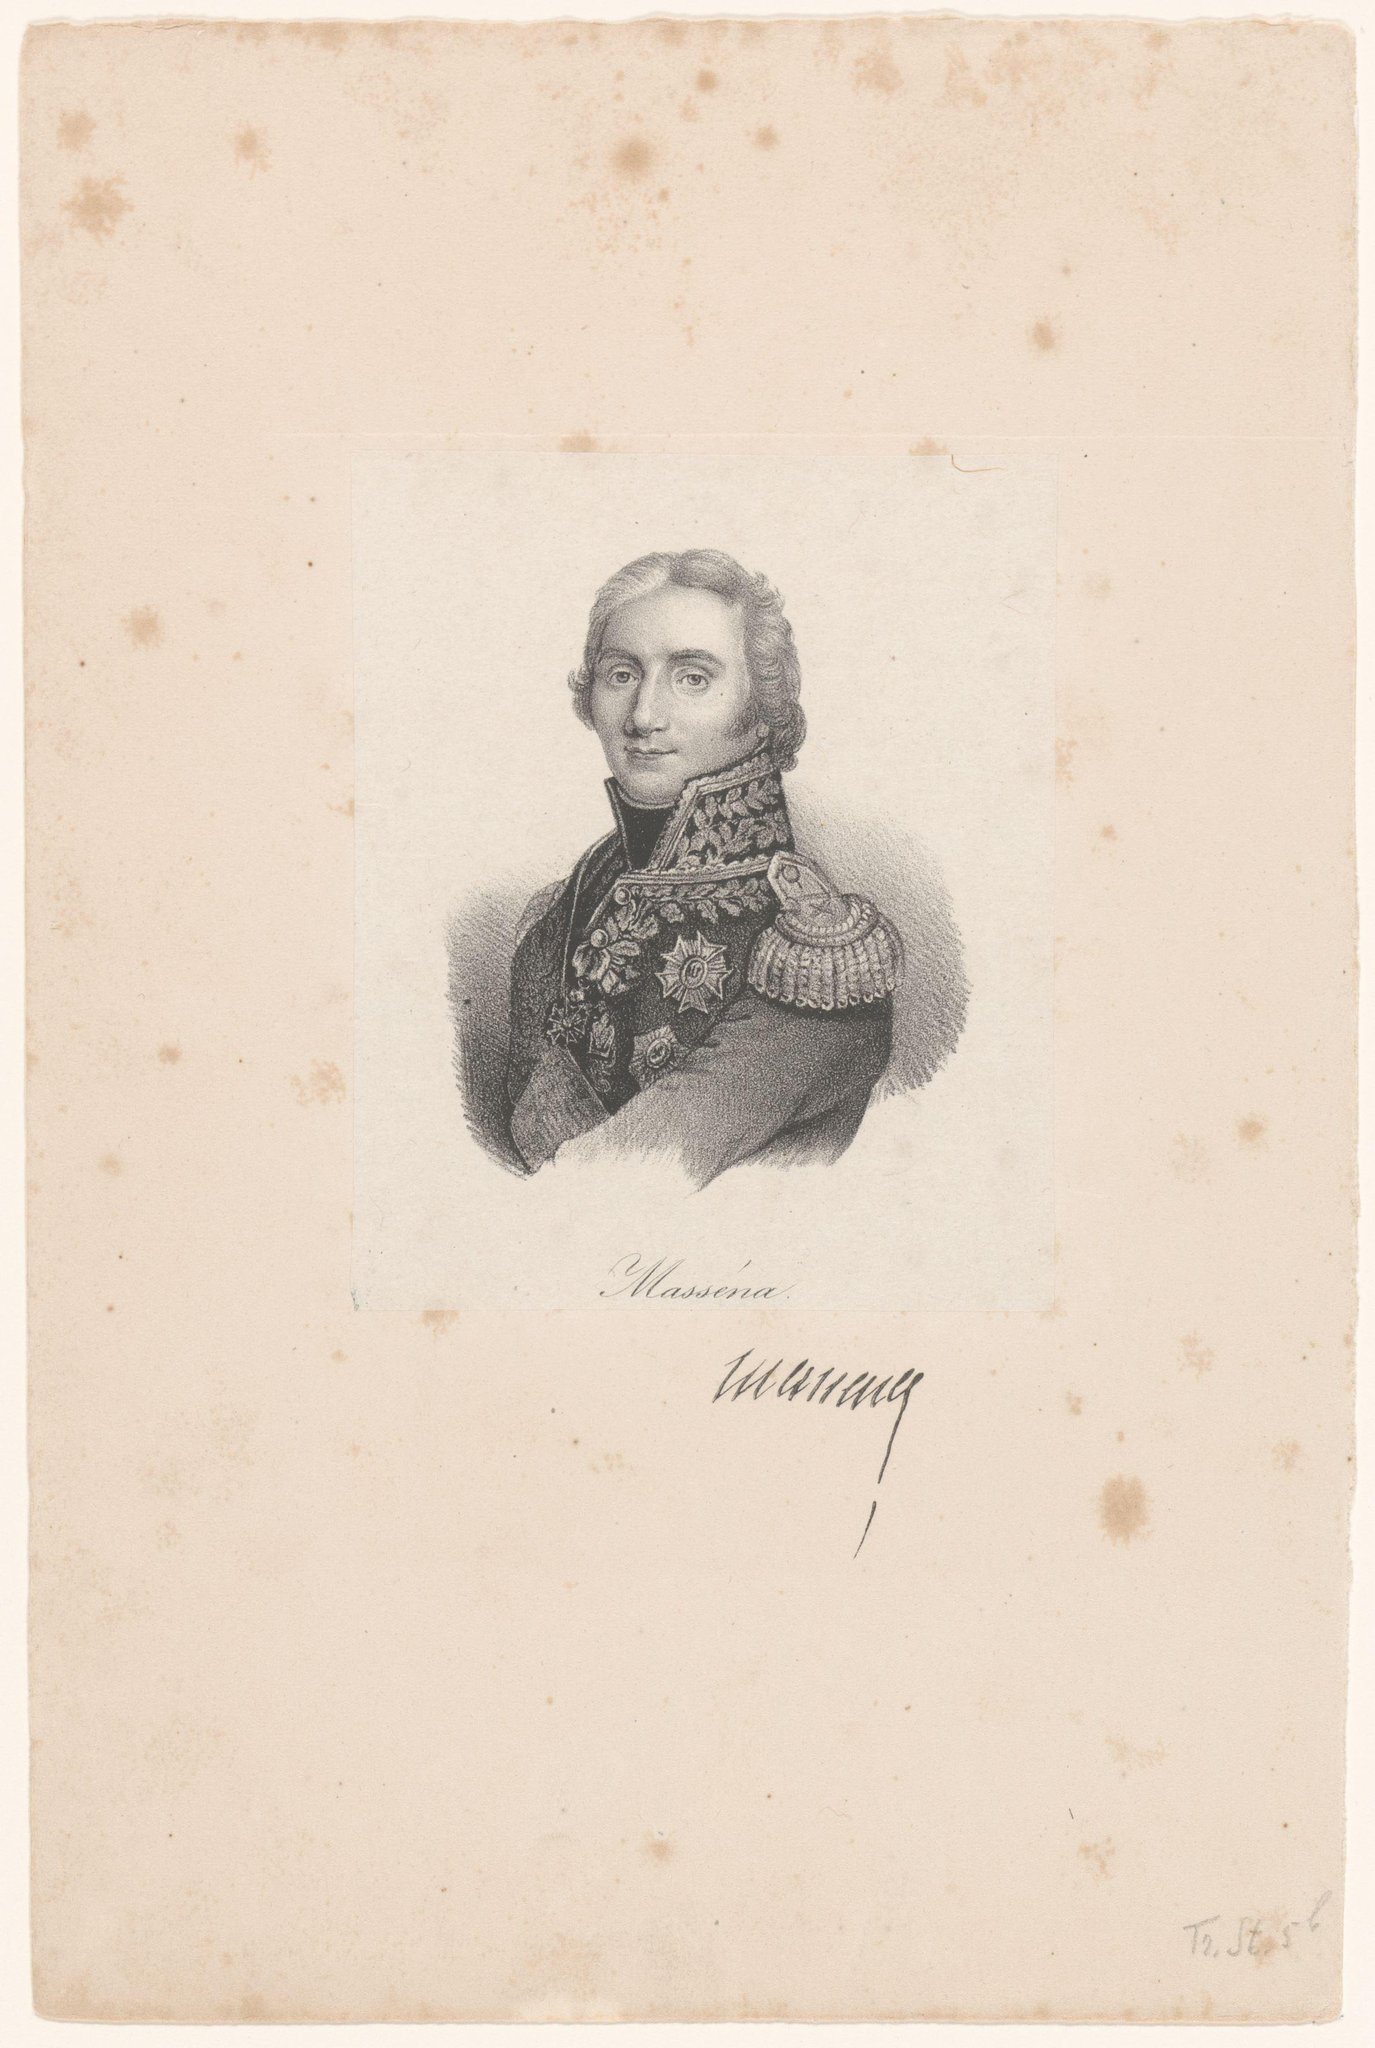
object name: print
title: Portret van André Masséna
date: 1818-1842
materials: paper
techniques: lithograph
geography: paris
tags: historical persons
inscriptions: collector's mark: Lugt 2228a